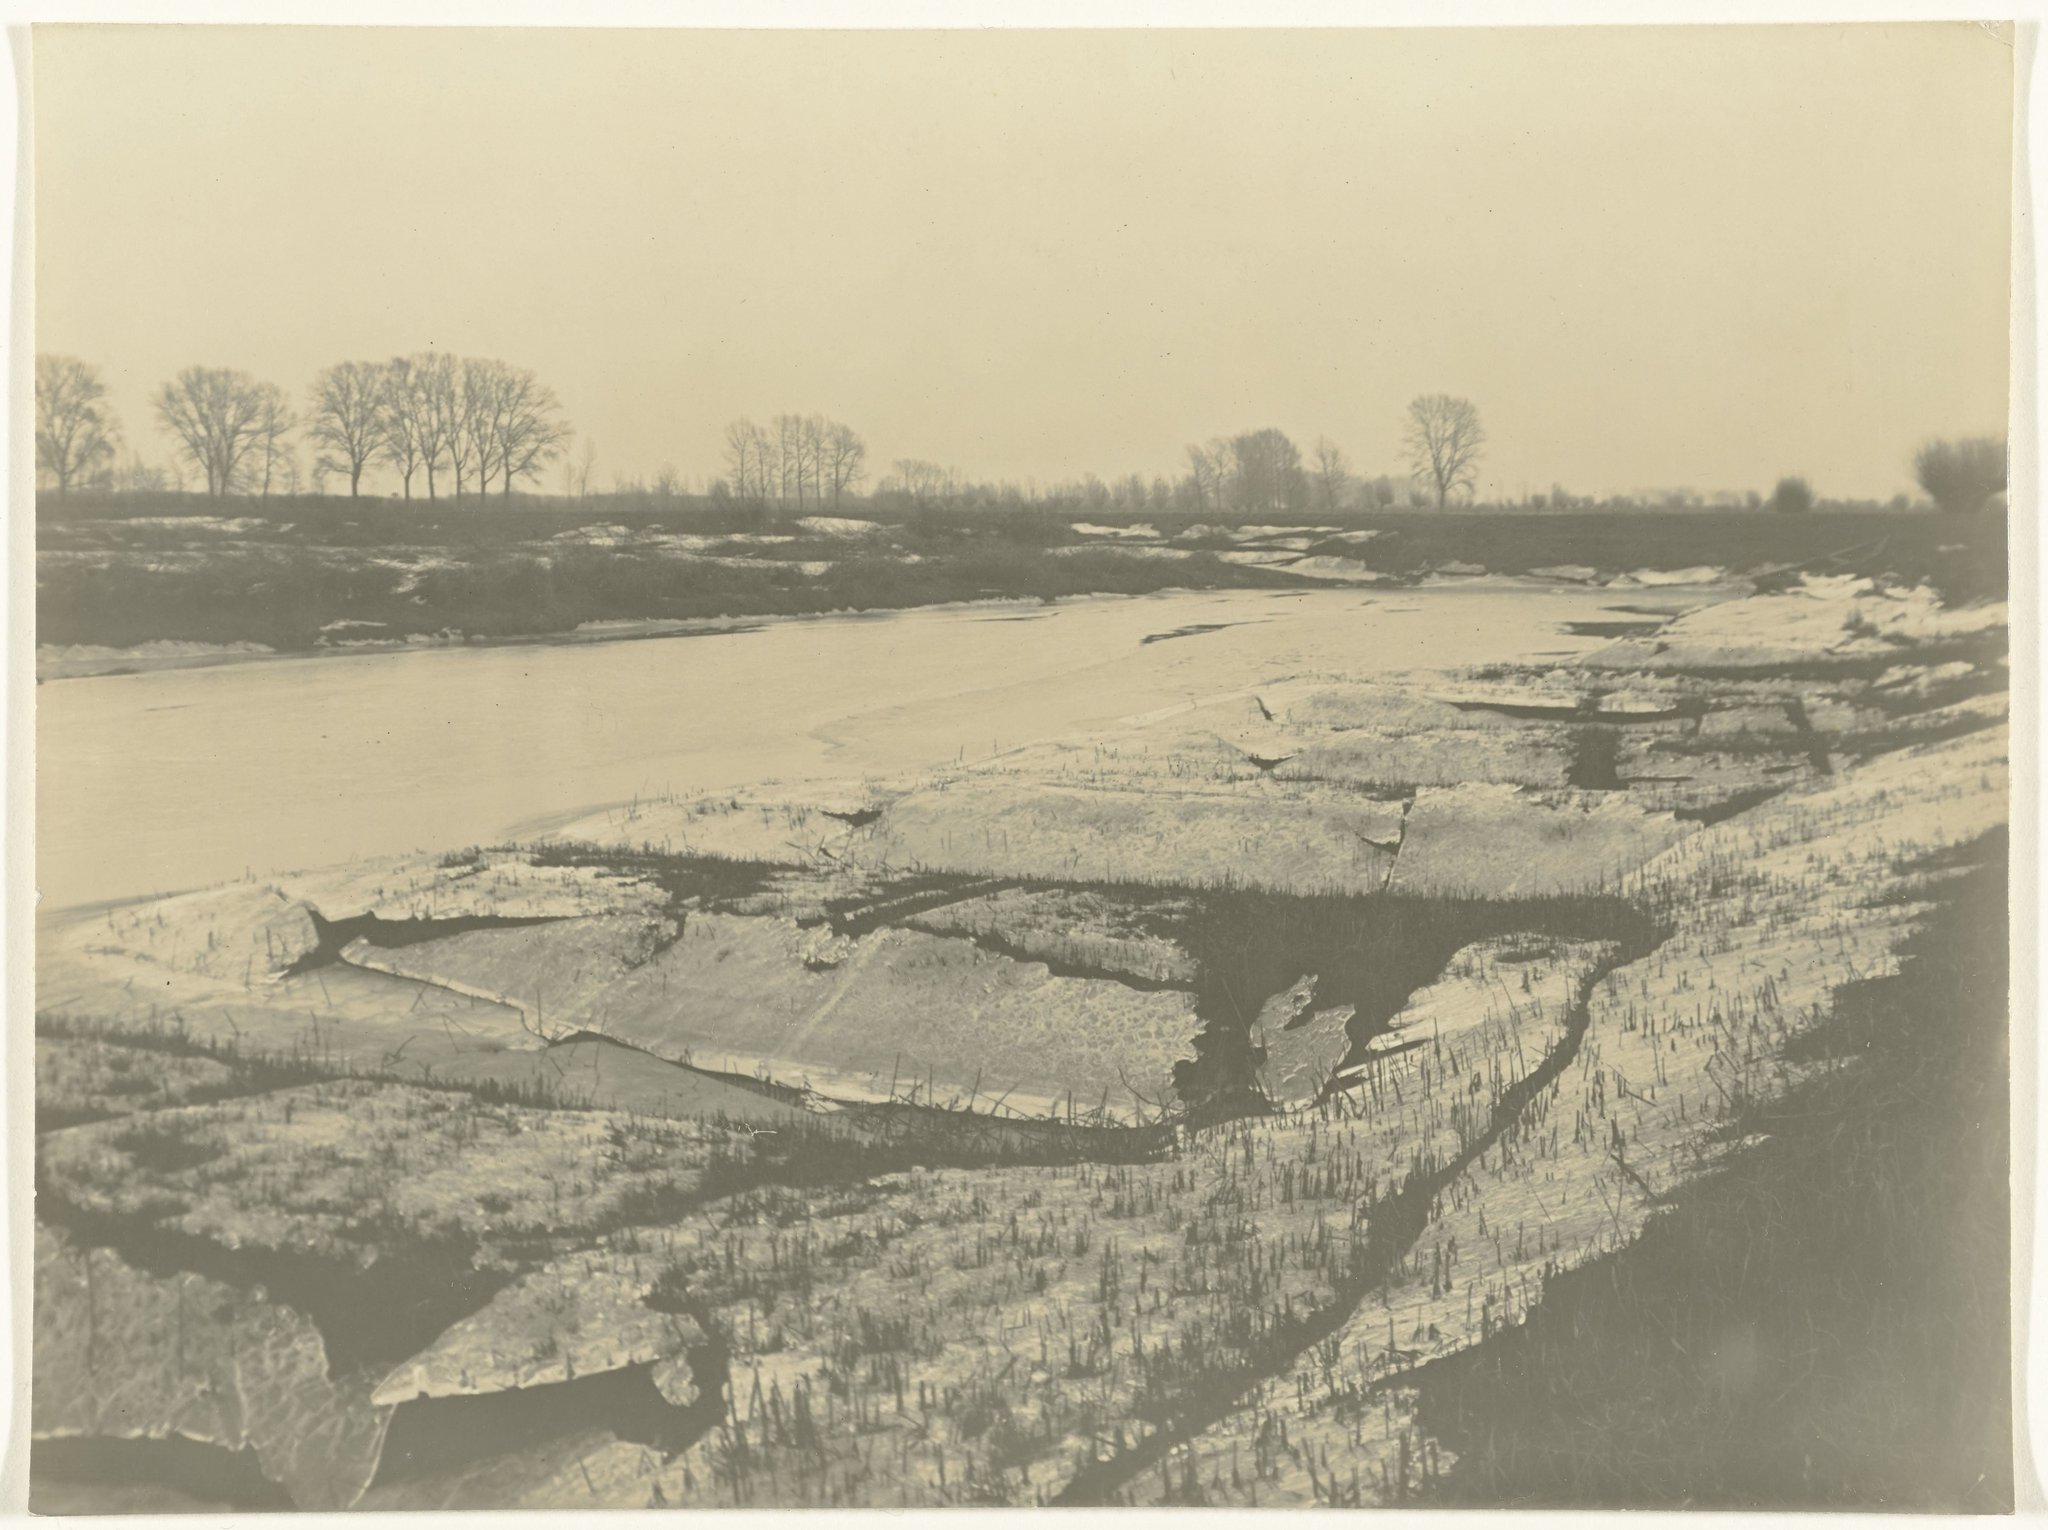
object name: photograph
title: Landgoed Nijenbeek In den Winter tusschen het Kasteel en den IJssel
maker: richard tepe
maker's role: fotograaf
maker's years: 1864-1952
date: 1900-1930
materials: cardboard, paper, photographic support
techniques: gelatin silver print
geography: netherlands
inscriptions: annotation: ‘Landgoed Nijenbeek / In den Winter tusschen het Kasteel / en den IJssel’